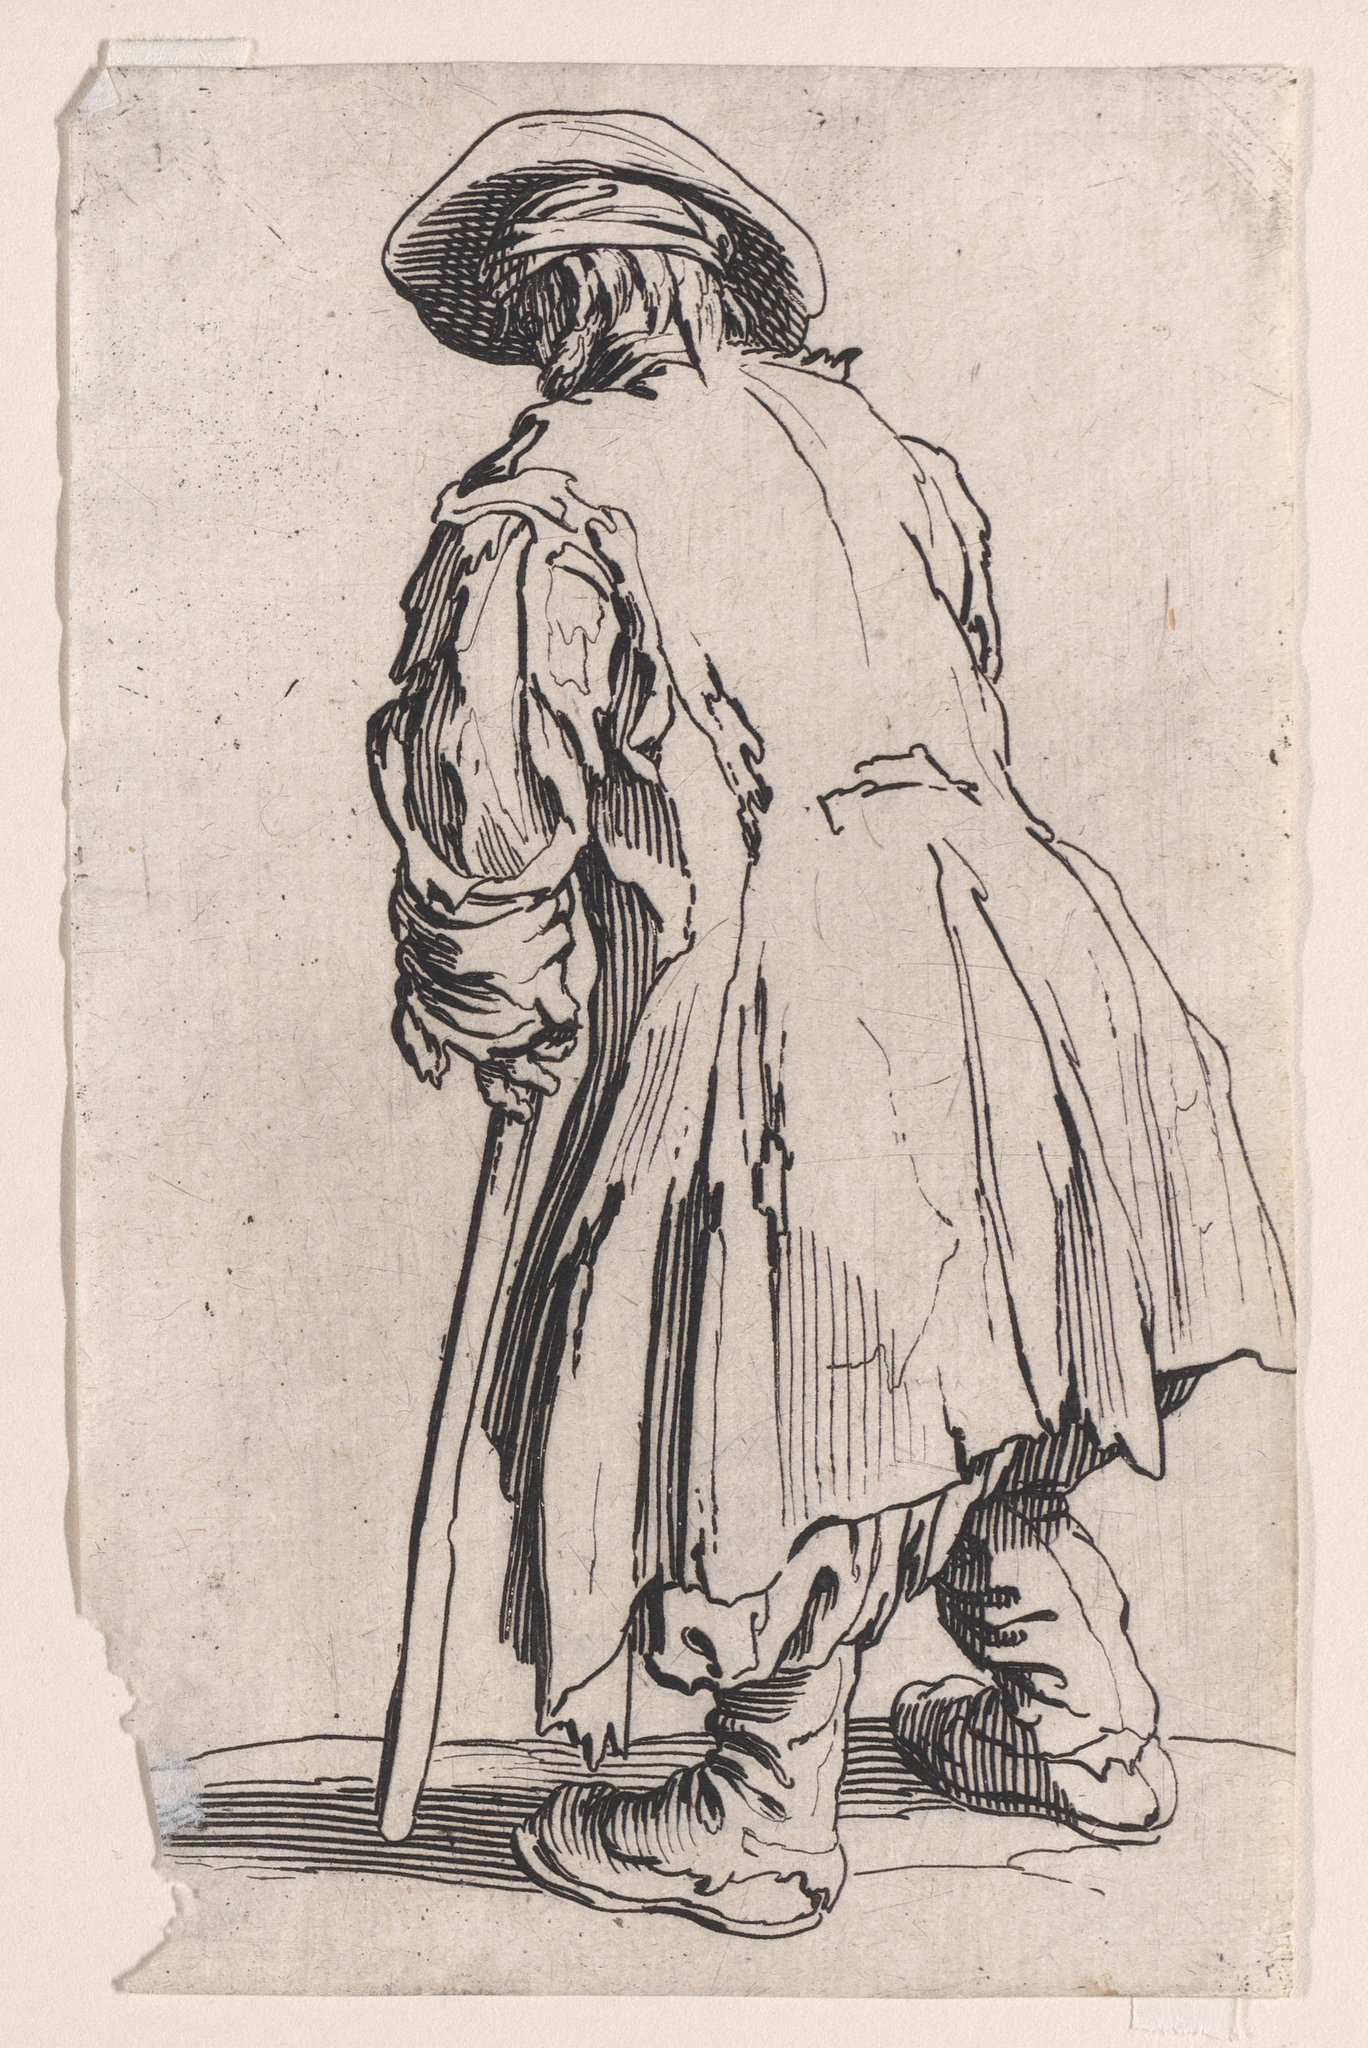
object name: print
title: Le Vieux Mendiant a une Seule Béquille (The Old Beggar with One Crutch), from "Les Gueux suite appelée aussi Les Mendiants, Les Baroni, ou Les Barons" (The Beggars, also called the Barons)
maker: jacques callot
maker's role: artist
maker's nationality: french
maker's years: 1592-1635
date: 1623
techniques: etching